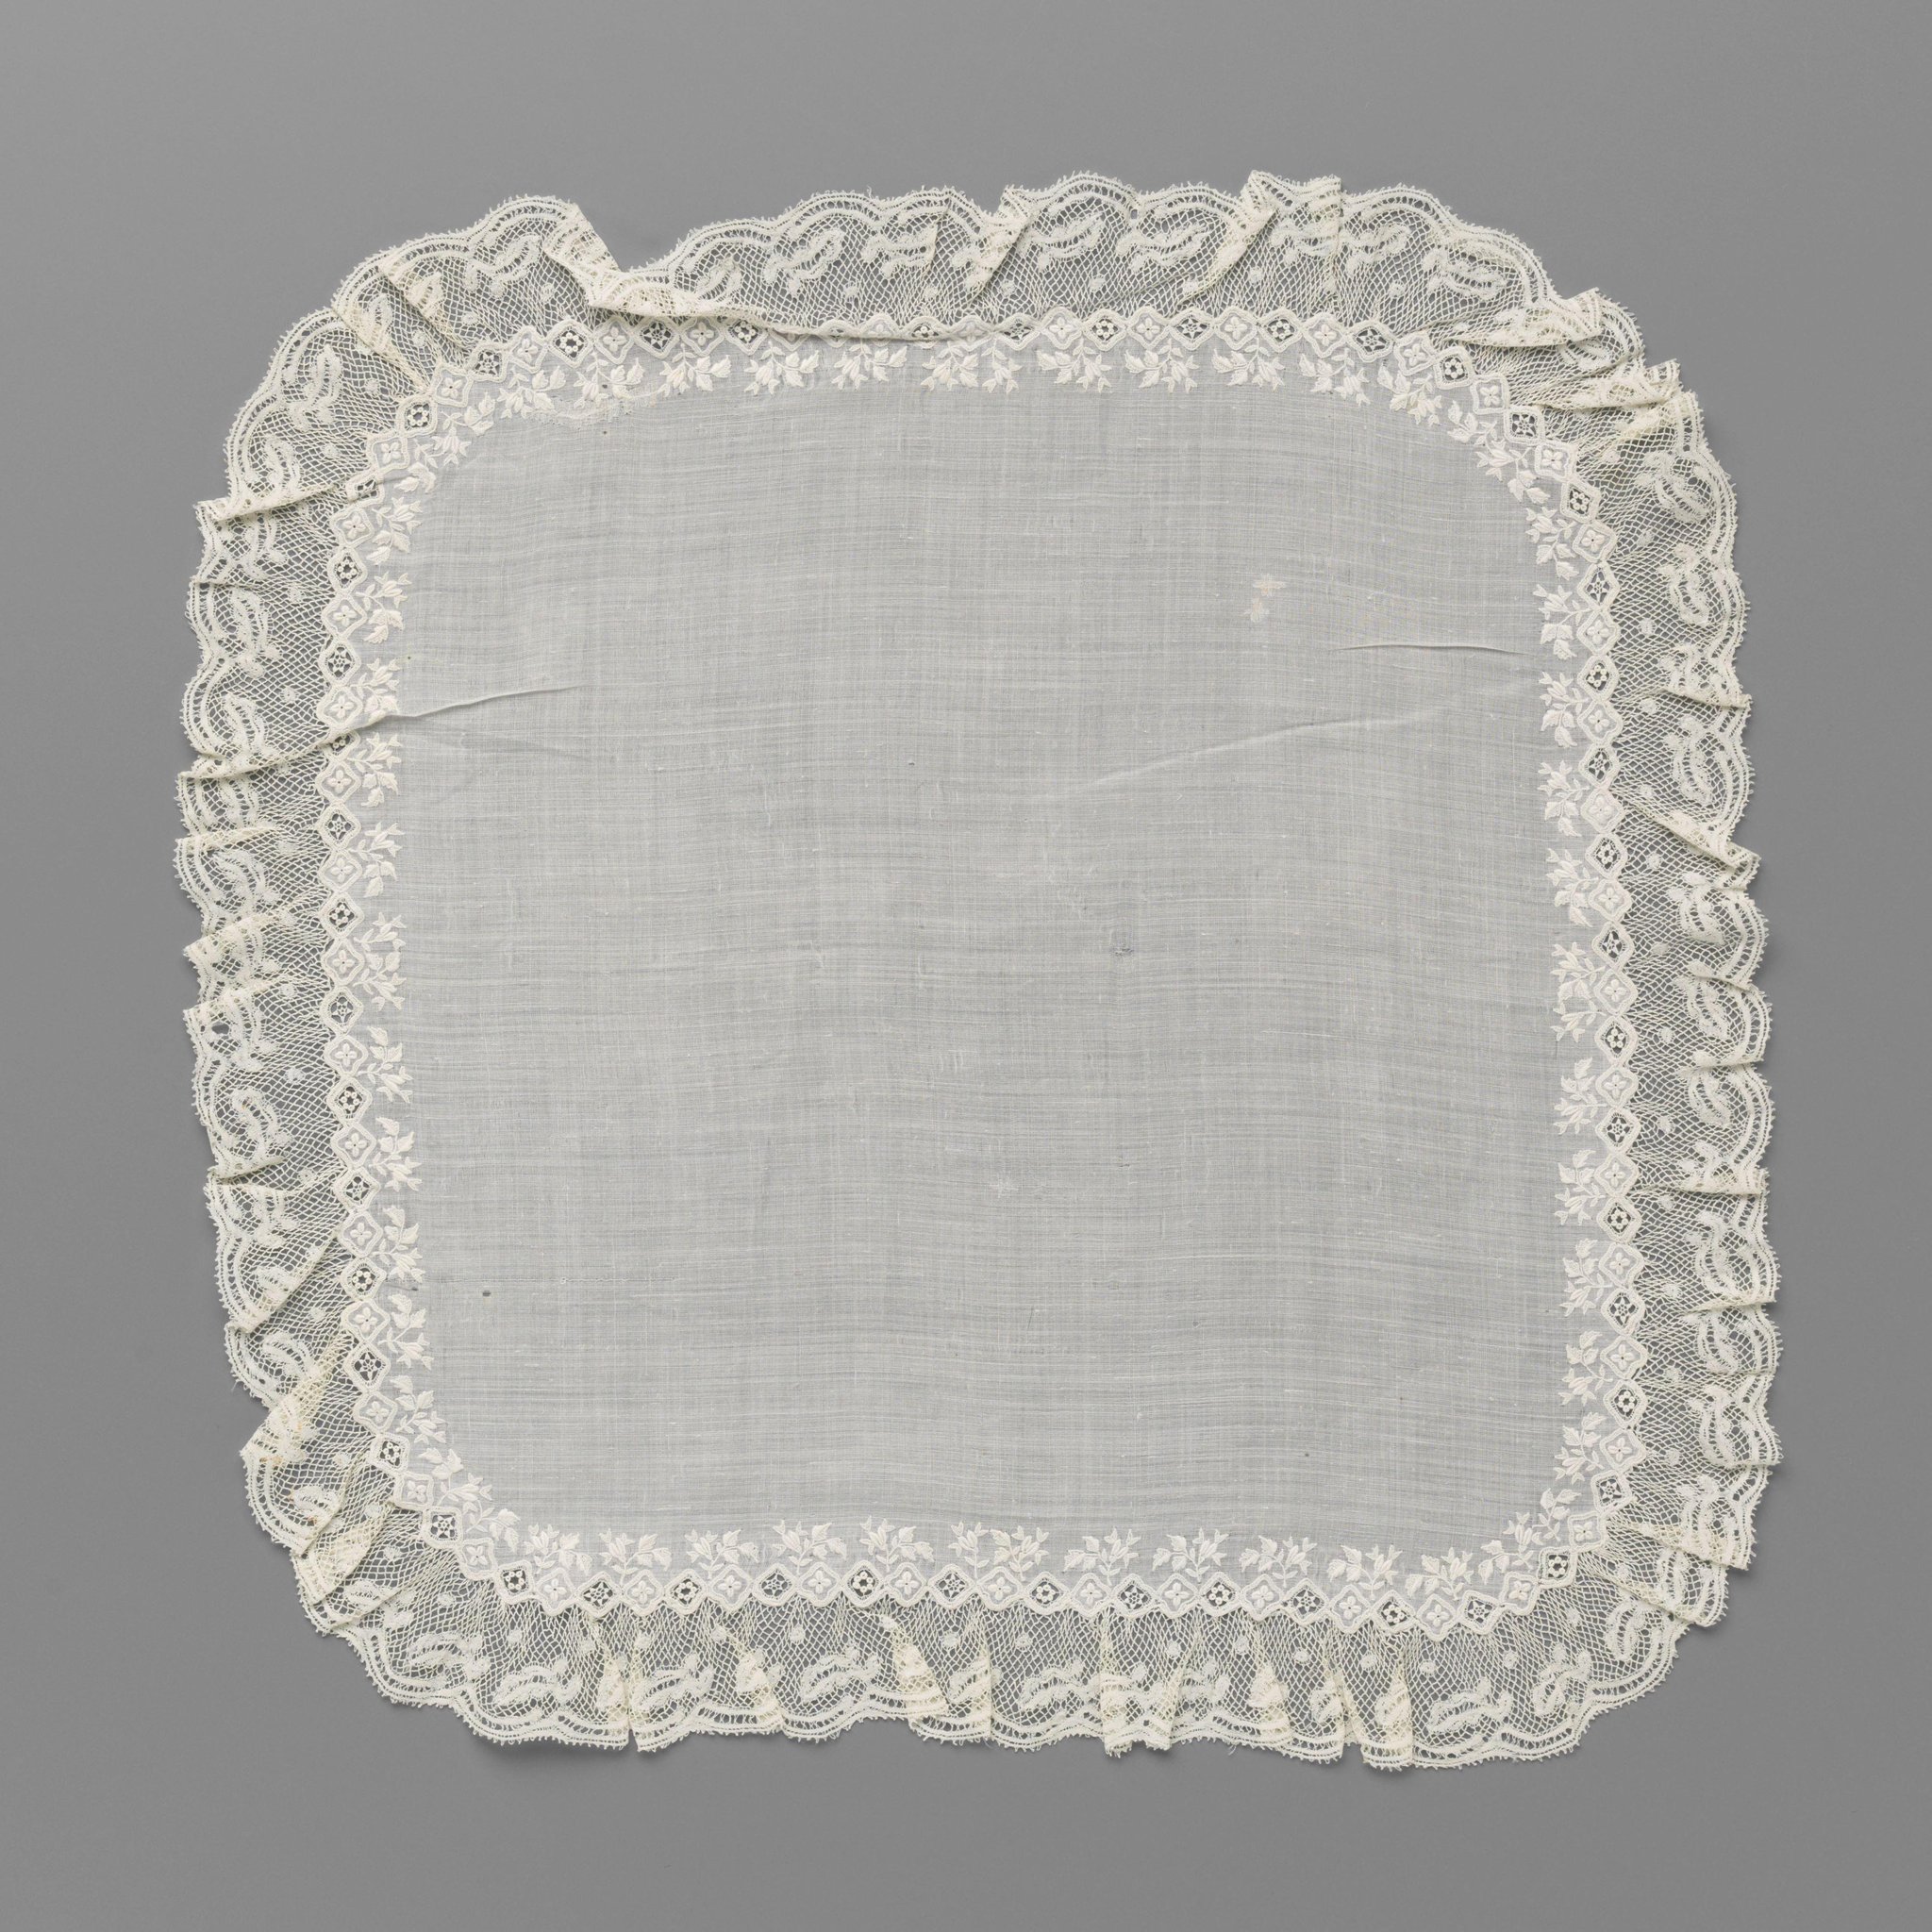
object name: handkerchief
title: Zakdoek van batist met plumetis borduurwerk en een rand kloskant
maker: Anonymous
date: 1890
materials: cotton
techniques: lace, embroidered, weave, embroidery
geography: europe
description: Zakdoek van batist met plumetis borduurwerk en een rand kloskant: Valenciennes-kant. Vierkant model met afgeronde hoeken. Het borduurwerk bevindt zich uitsluitend langs de rand van het weefsel. Het patroon bestaat uit een keten van ruitjes, afwisselend opgewerkt en voorzien van een sterbloempje, een rozetbloempje met vier blaadjes en een bloempje met zes ronde bloemblaadjes. Tussen de ruitjes ontspringen kleine bladertakjes. Het kant is iets gerimpeld aan het textiel gezet en heeft een zich herhalend patroon van een eenzijdig gericht blad met schuin daarboven een moesje met uitsparing. Het blad ontspringt aan het patroon langs de onderrand dat bestaat uit een keten van liggende boogjes die de schulpenrand vormen. De schulpenrand is afgewerkt met picots. De motieven zijn gemaakt in linnenslag met opengewerkte randjes en uitsparingen. De motieven zijn met elkaar verbonden door een traliegrond: een vierkante Valenciennes-grond.